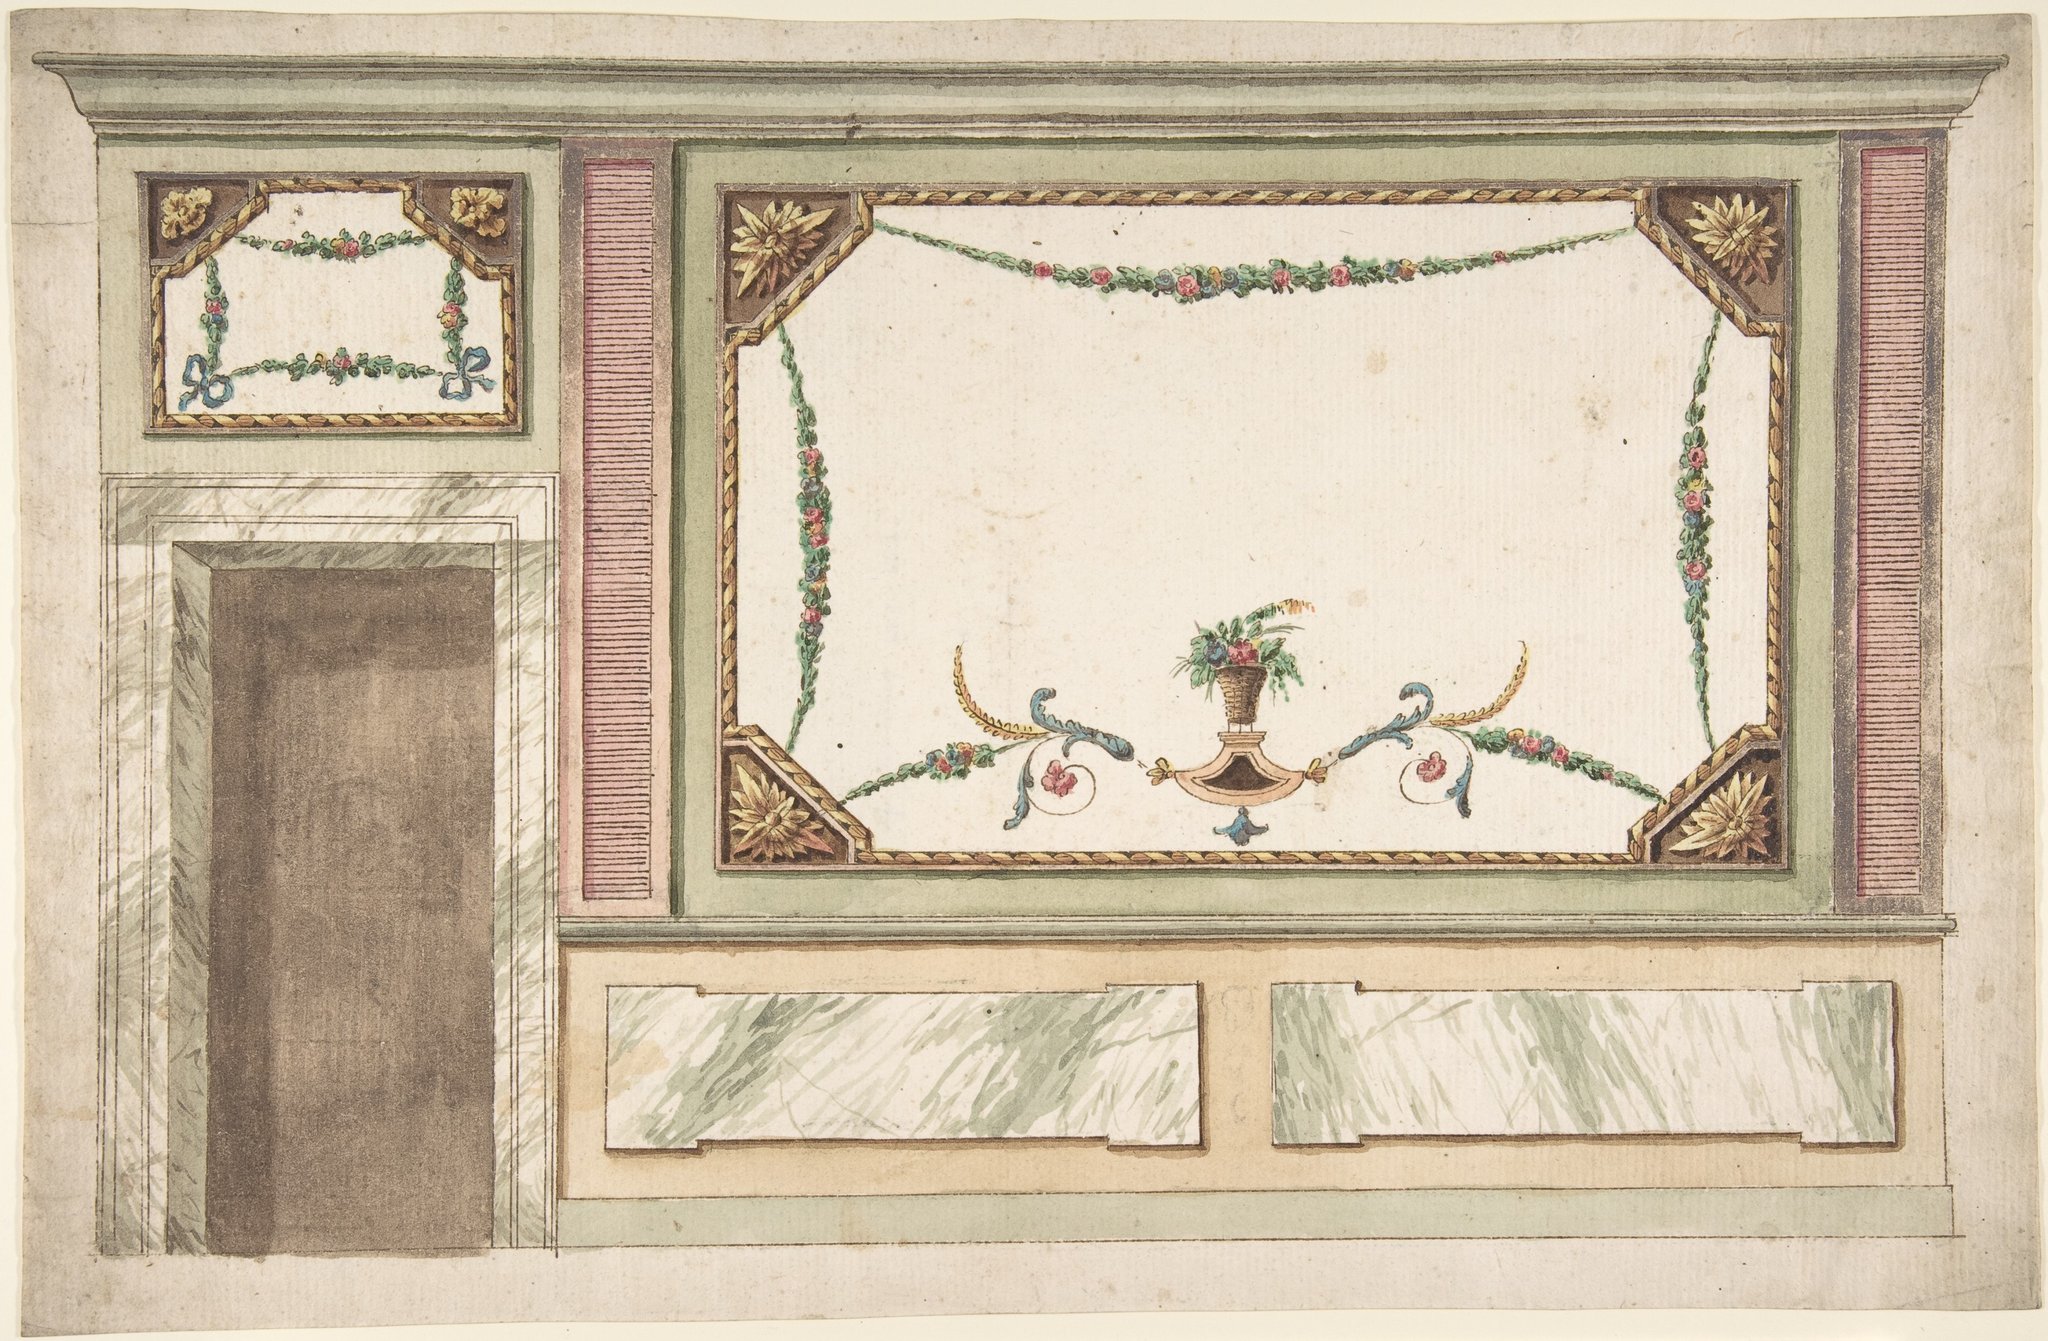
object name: drawing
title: Design for a Wall Decoration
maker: anonymous, italian, 18th century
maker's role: artist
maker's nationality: italian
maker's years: 1700-1800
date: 1701-1800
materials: ink, watercolor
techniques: wash